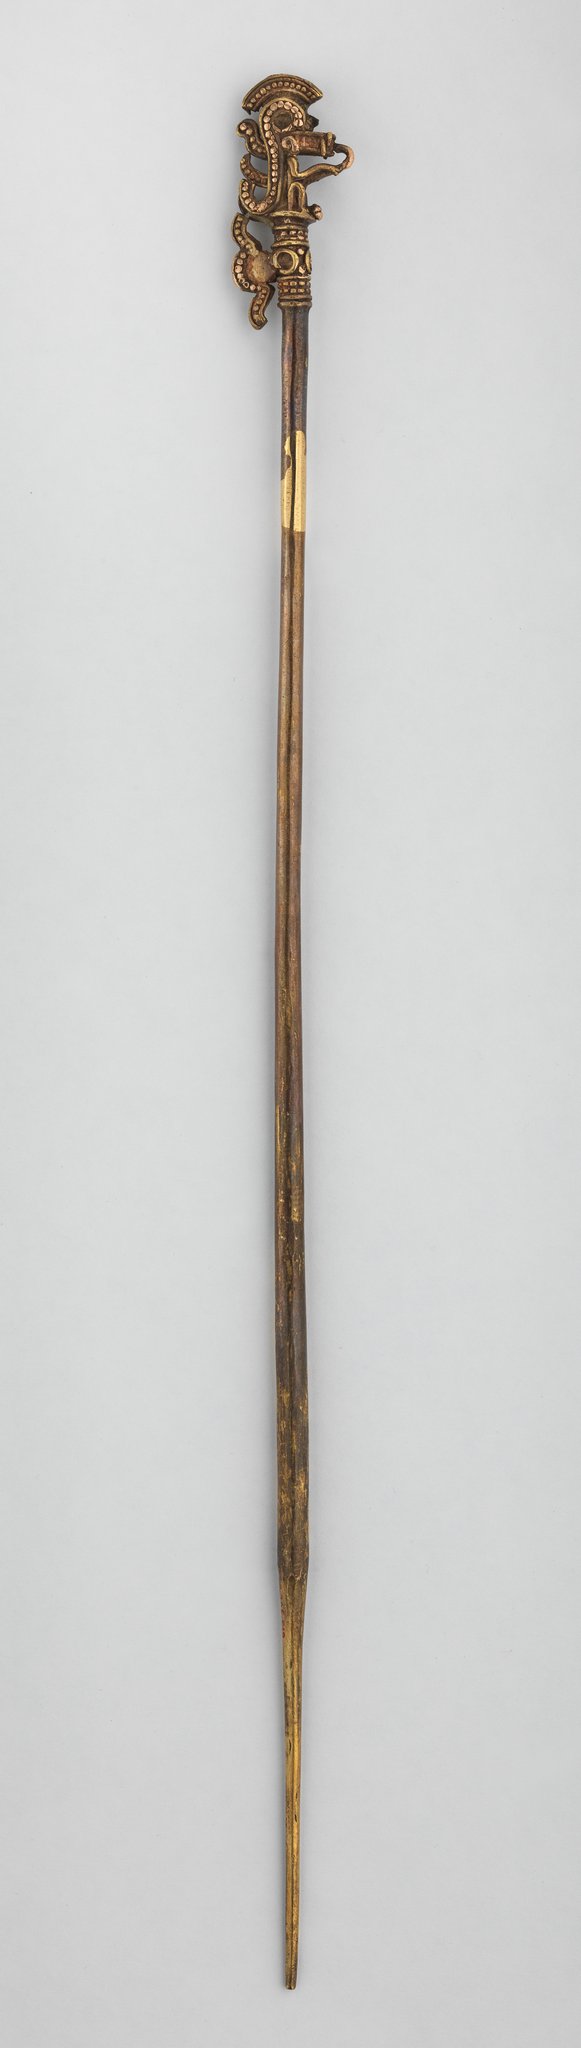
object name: lime spatula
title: Lime Dipper or Pin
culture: calima or yotoco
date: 1-700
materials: gold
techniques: casting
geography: colombia